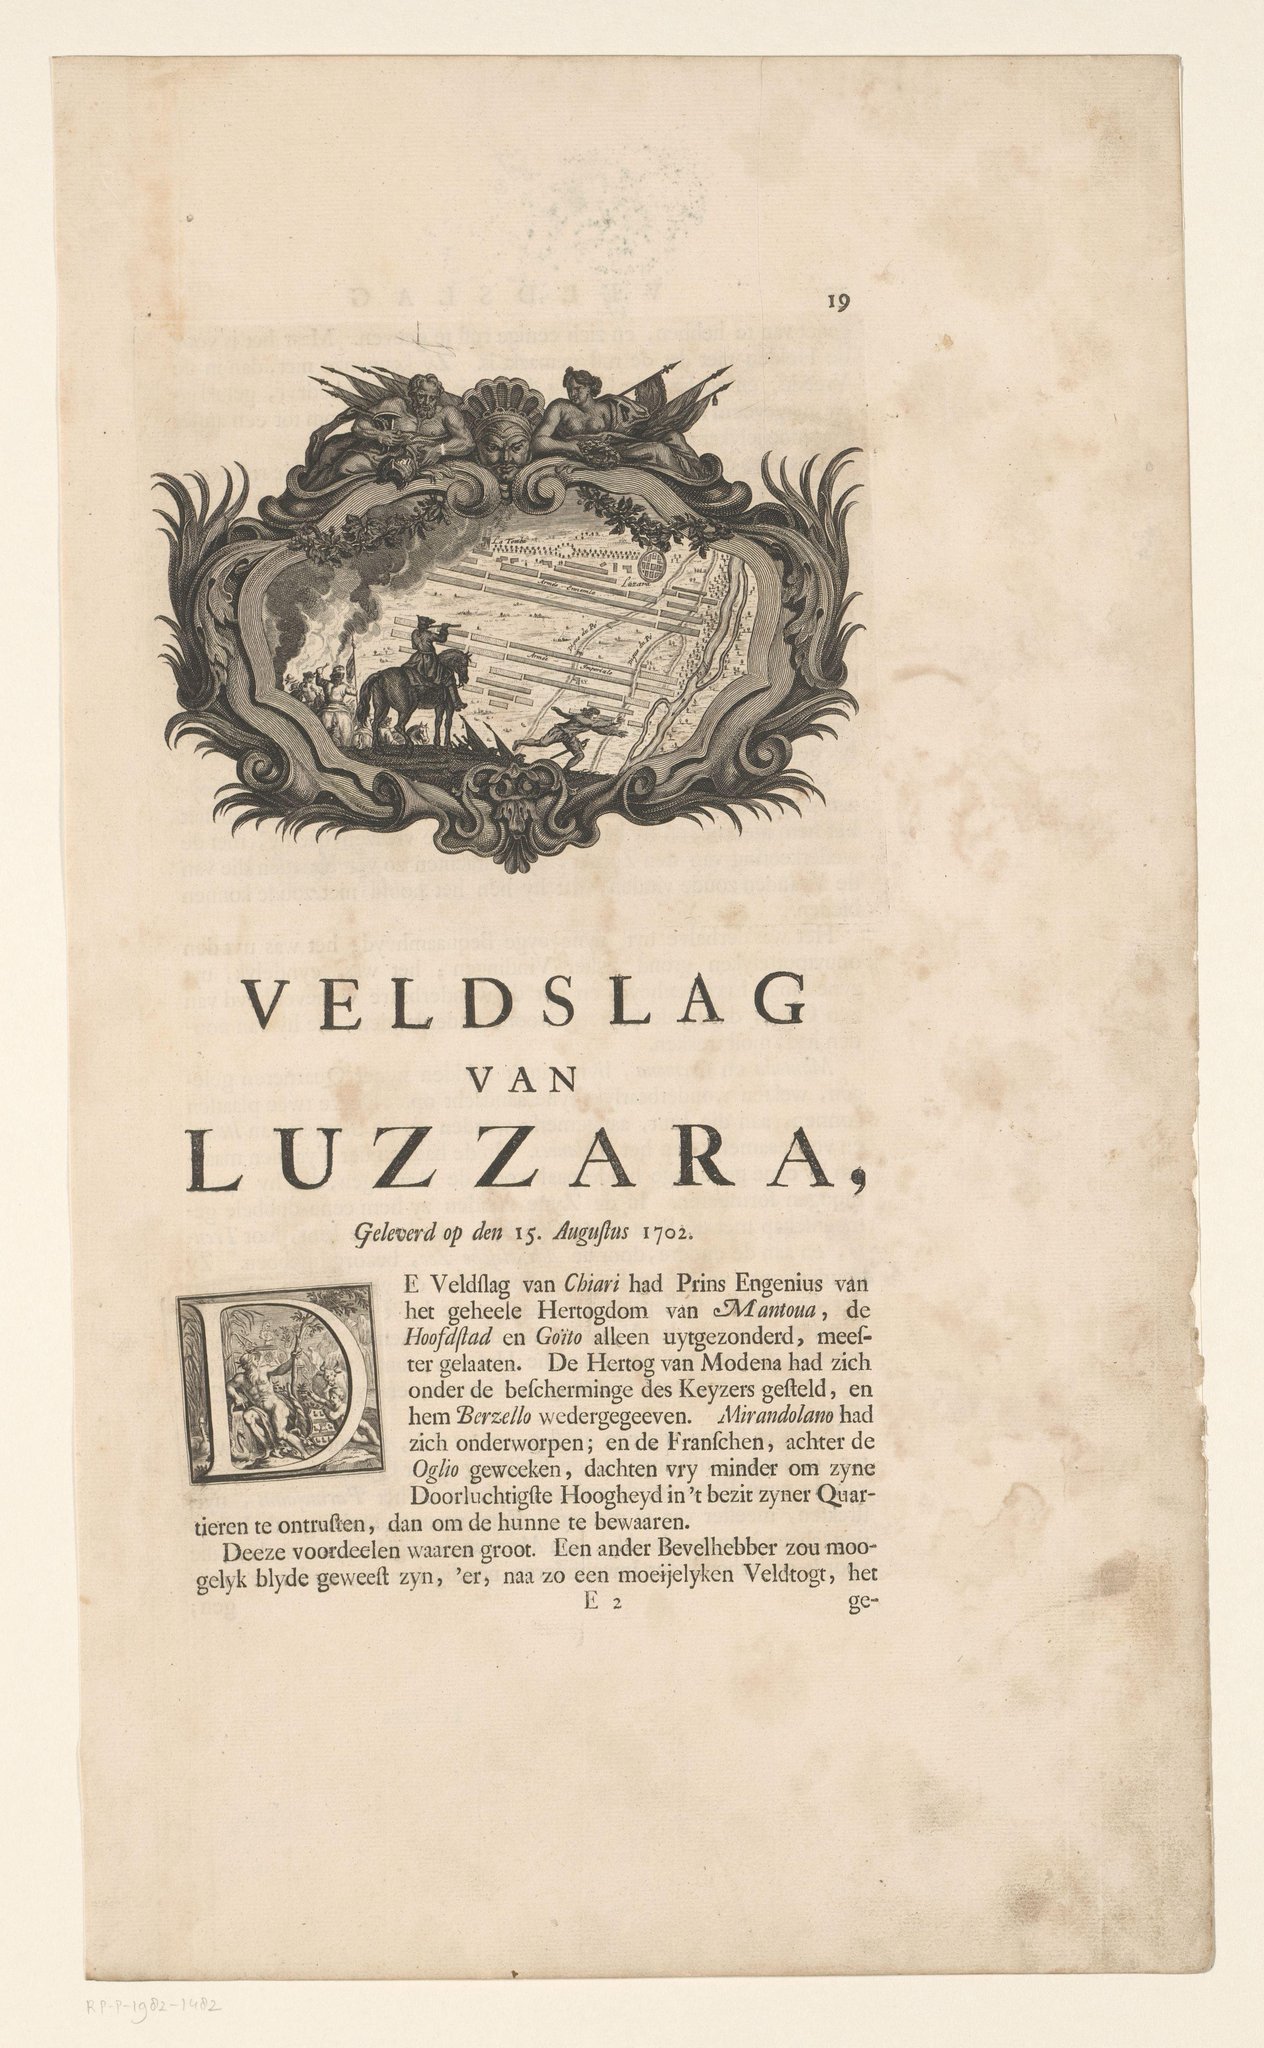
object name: print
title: Slag bij Luzzara, 1702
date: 1729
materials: paper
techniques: etching, letterpress printing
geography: northern netherlands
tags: paris, eugenius van savoye, land forces (+ cavalry, horsemen), river, battle (+ land forces), plan of battle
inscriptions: collector's mark: Lugt 2228, collector's mark: Lugt 2760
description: Blad bedrukt met tekst op beide zijden, een gegraveerde initiaal D en een cartouche met een voorstelling van de veldslag bij Luzzara met een overwinning van de Geallieerden onder prins Eugenius van Savoye op de Fransen en de Spanjaarden, 15 augustus 1702. Blad (Pag. 19-20) uit het eerste deel van: Jean du Mont, Oorlogskundige beschryving van de veldslagen en belegeringen, der drie ... wydvermaarde krygsoversten... den Prins Eugenius van Savoye, den ... Hertog van Marlborough, en den Prins van Oranje en Nassau-Vriesland, in de editie van 1729. Dit eerste deel is gewijd aan de daden van Eugenius, prins van Savoye.